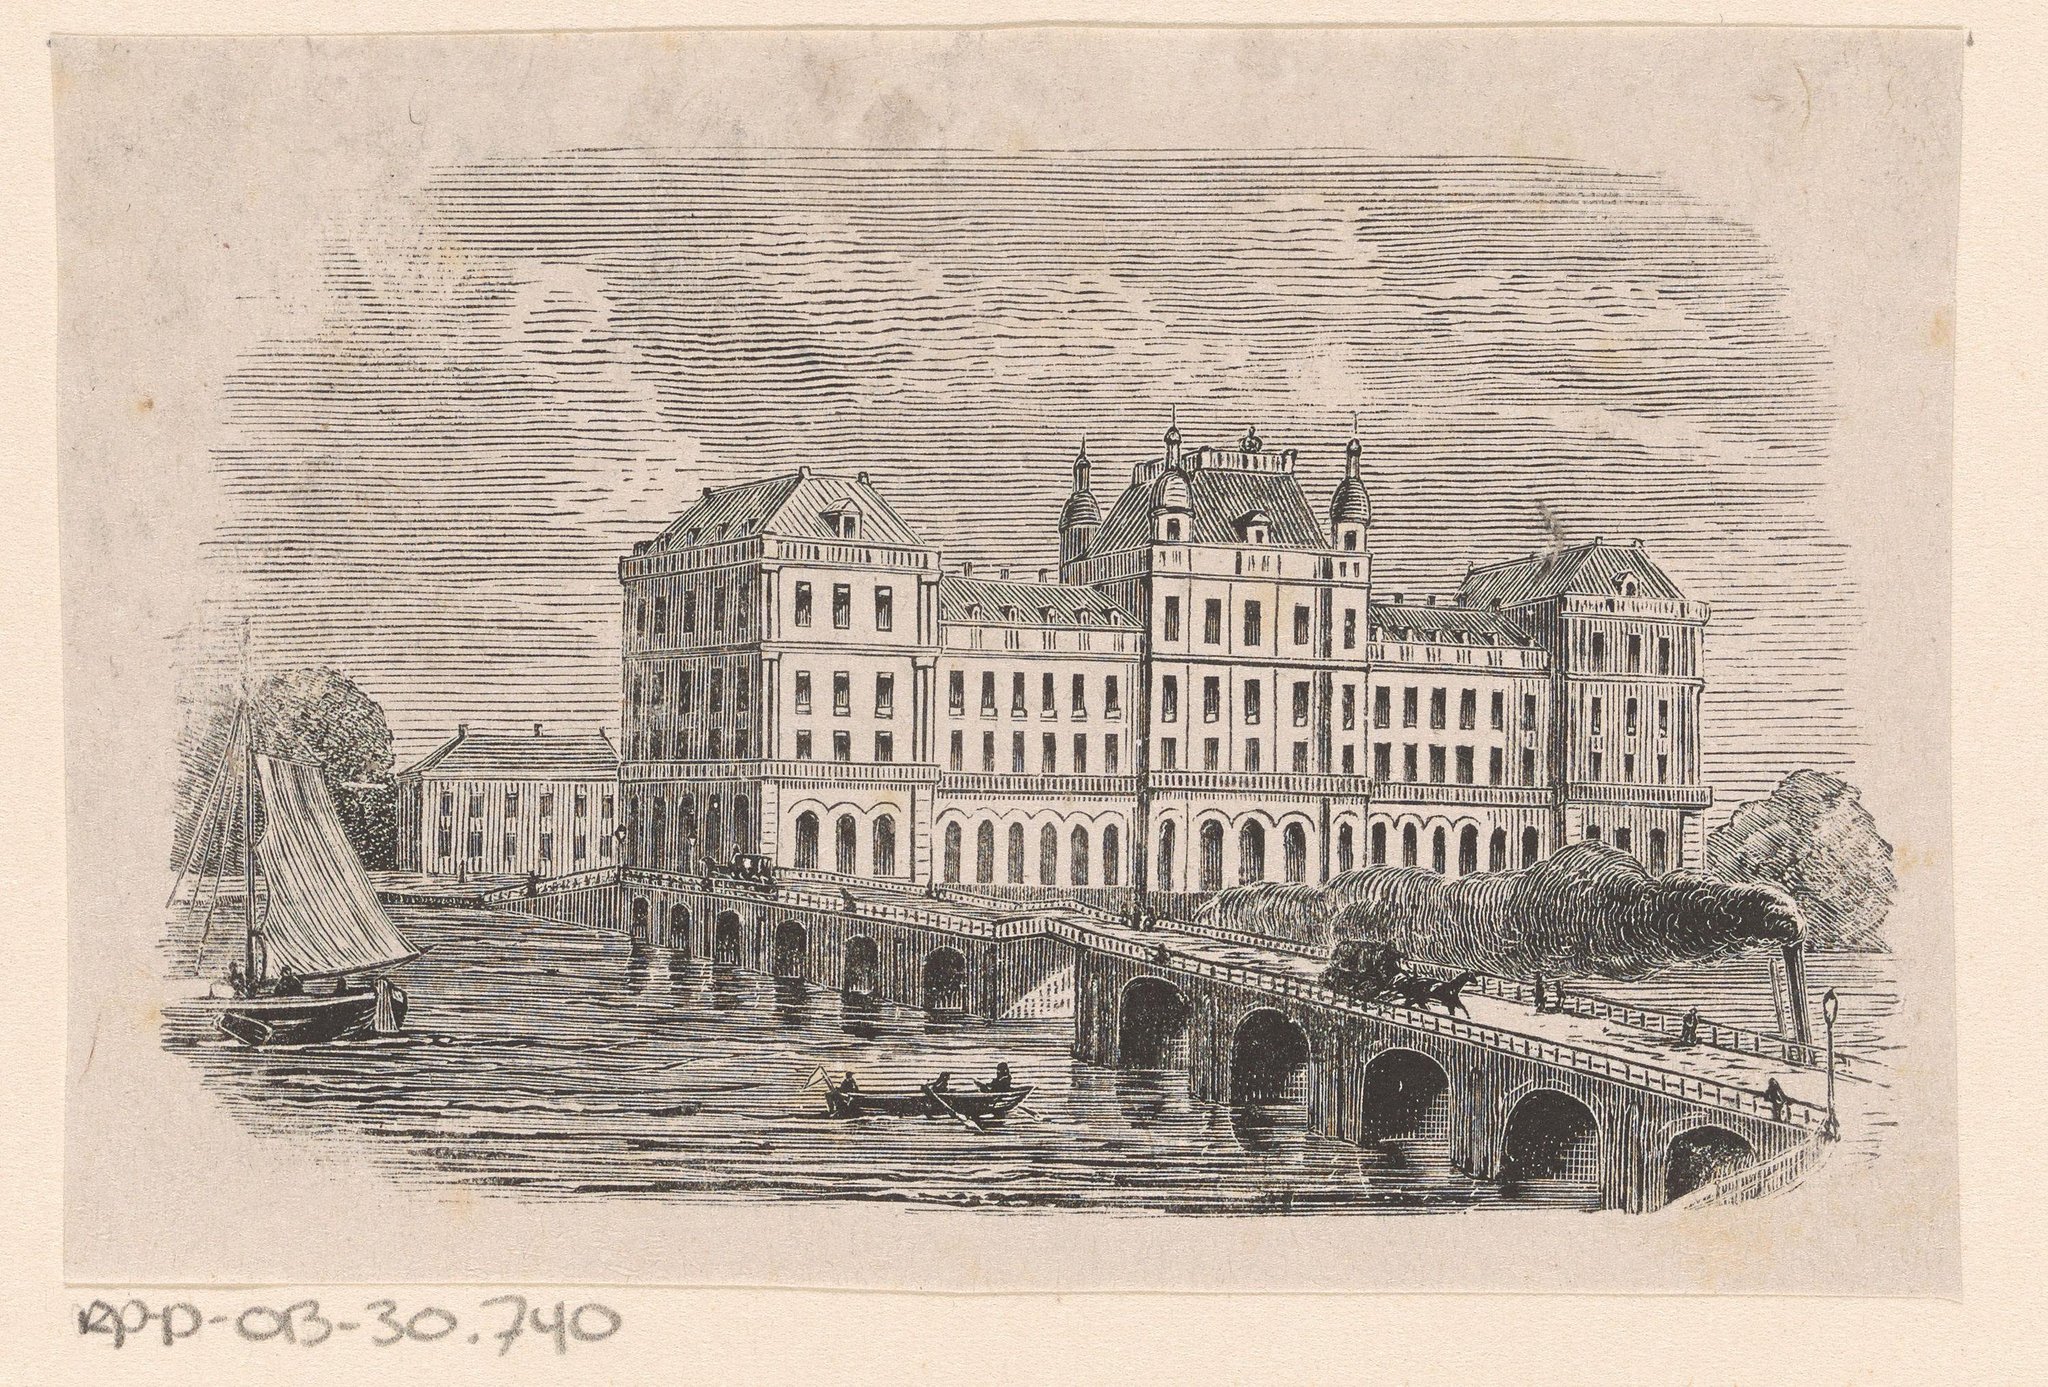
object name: print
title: Gezicht op het Amstel Hotel te Amsterdam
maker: isaac weissenbruch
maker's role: print maker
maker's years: 1826-1912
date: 1867-1912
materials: paper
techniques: engraving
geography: netherlands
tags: sailing-ship, sailing-boat, rowing-boat, canoe, etc., bridge in city across river, canal, etc., hotel, hostelry, inn, steamship, motorship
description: Op de voorgrond varen schepen onder de Hogesluisbrug over de rivier de Amstel.